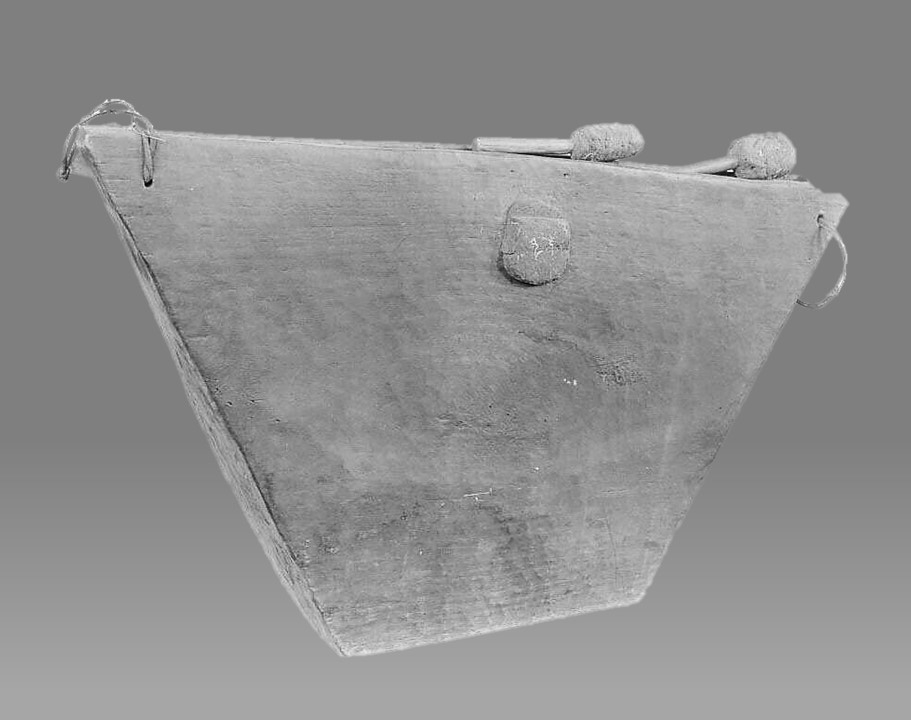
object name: slit gong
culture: angolan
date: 1801-1900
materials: textile, leather, wax, wood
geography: angola